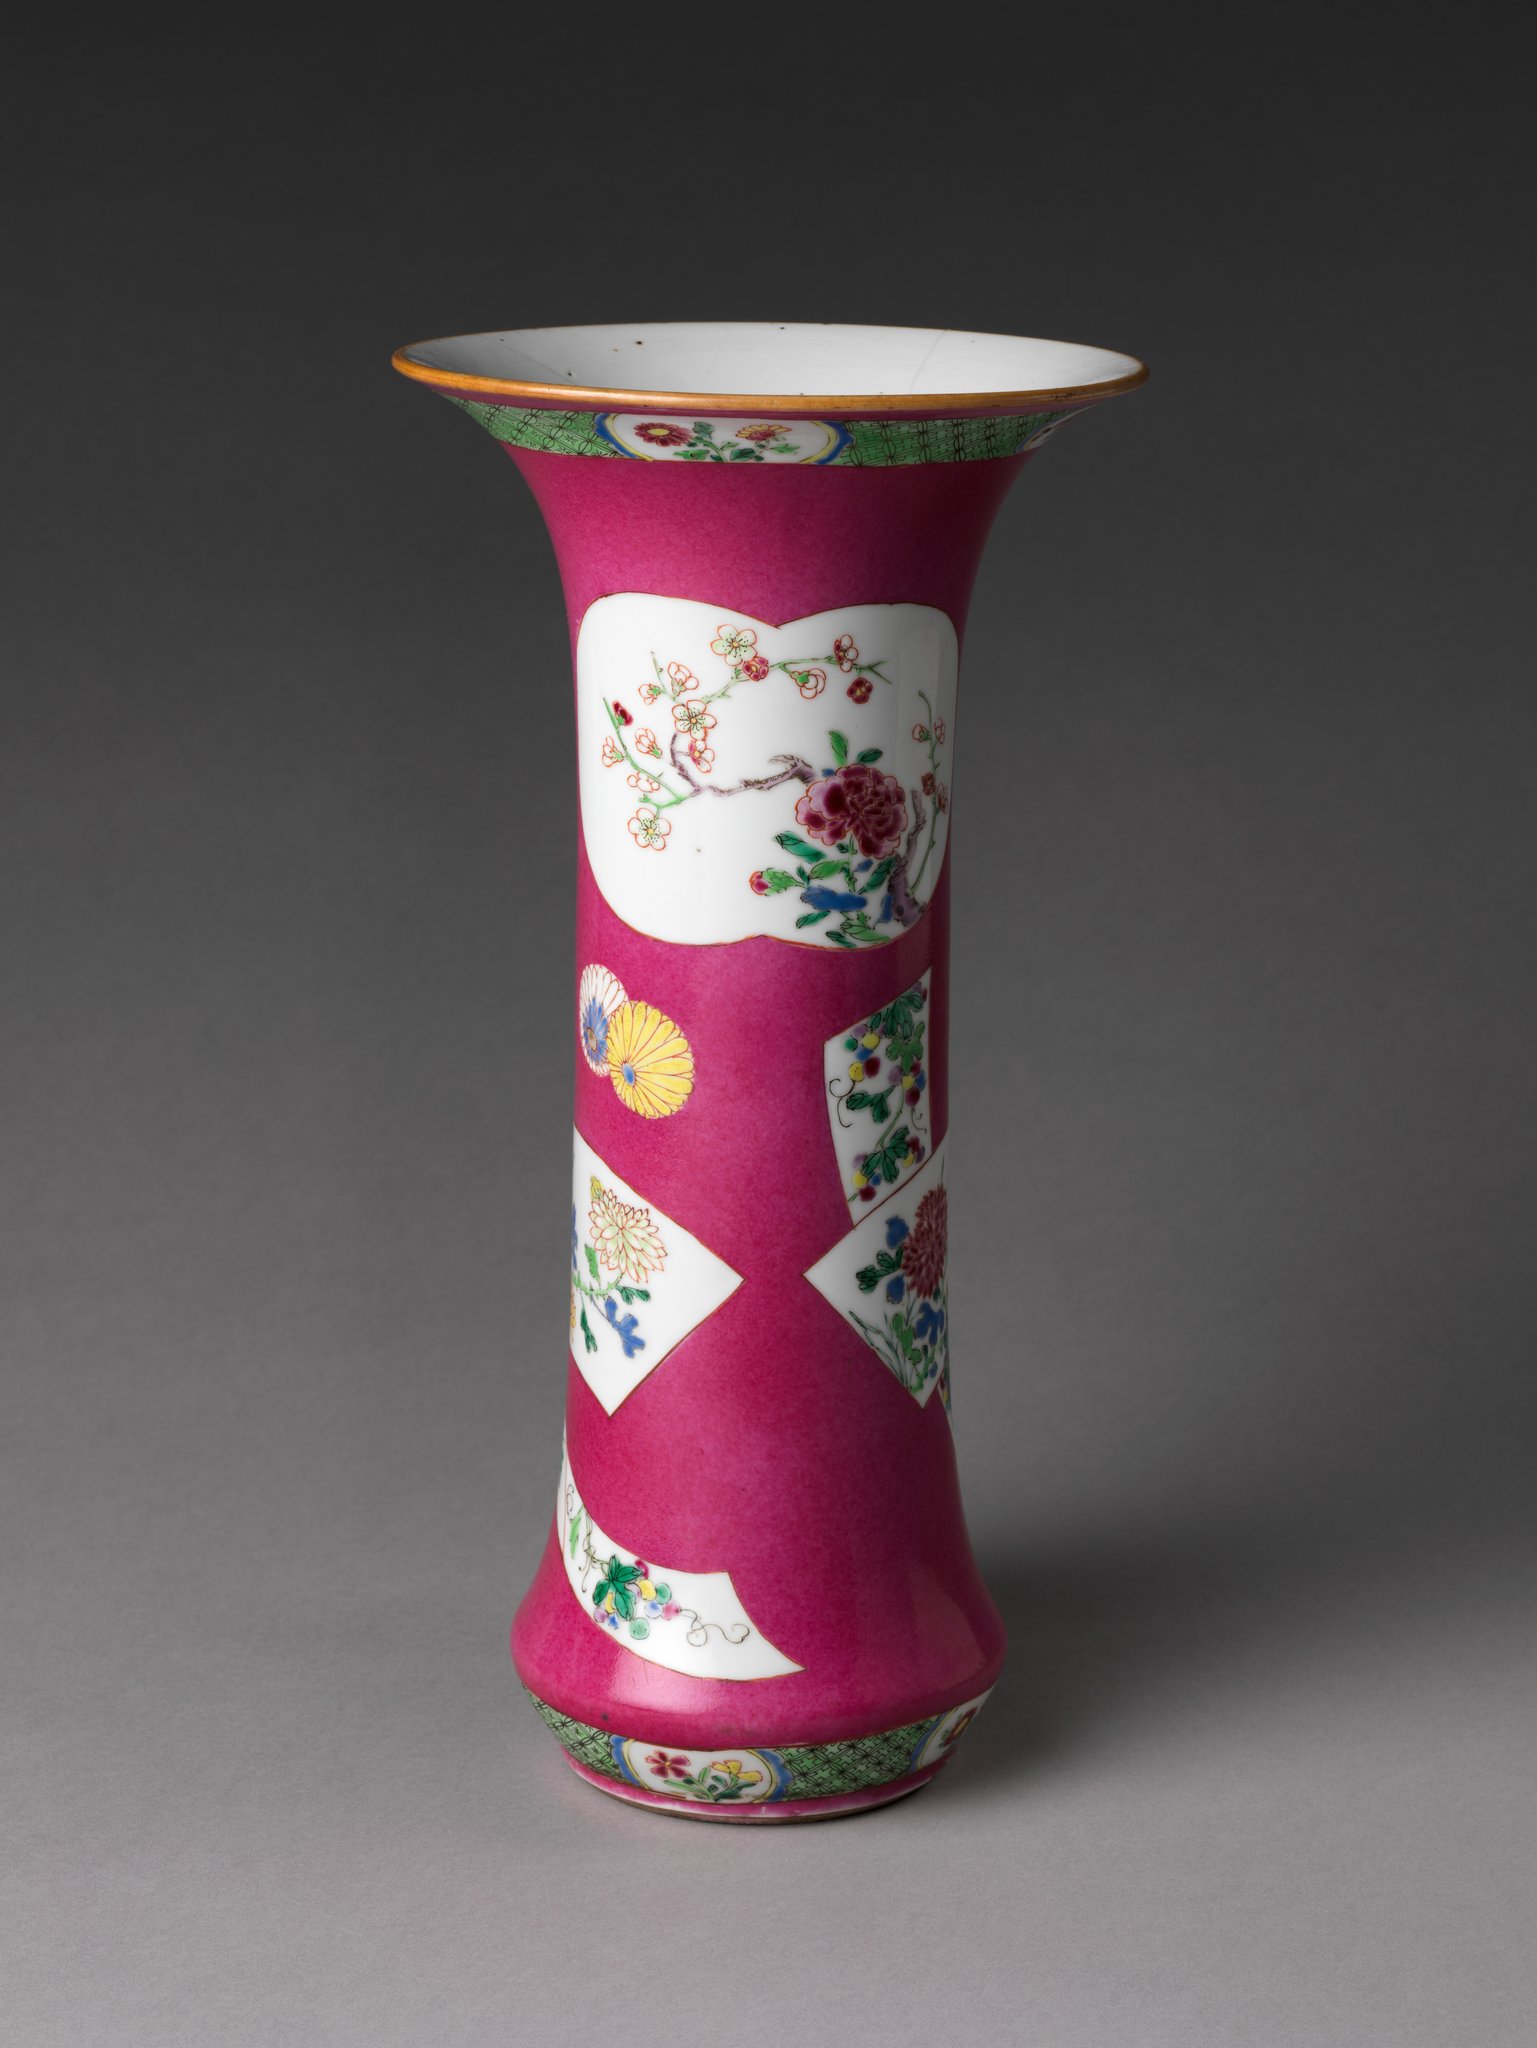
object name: vase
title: Vase with Flowers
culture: chinese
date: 1734-1766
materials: enamel, glaze, porcelain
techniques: painting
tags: flowers